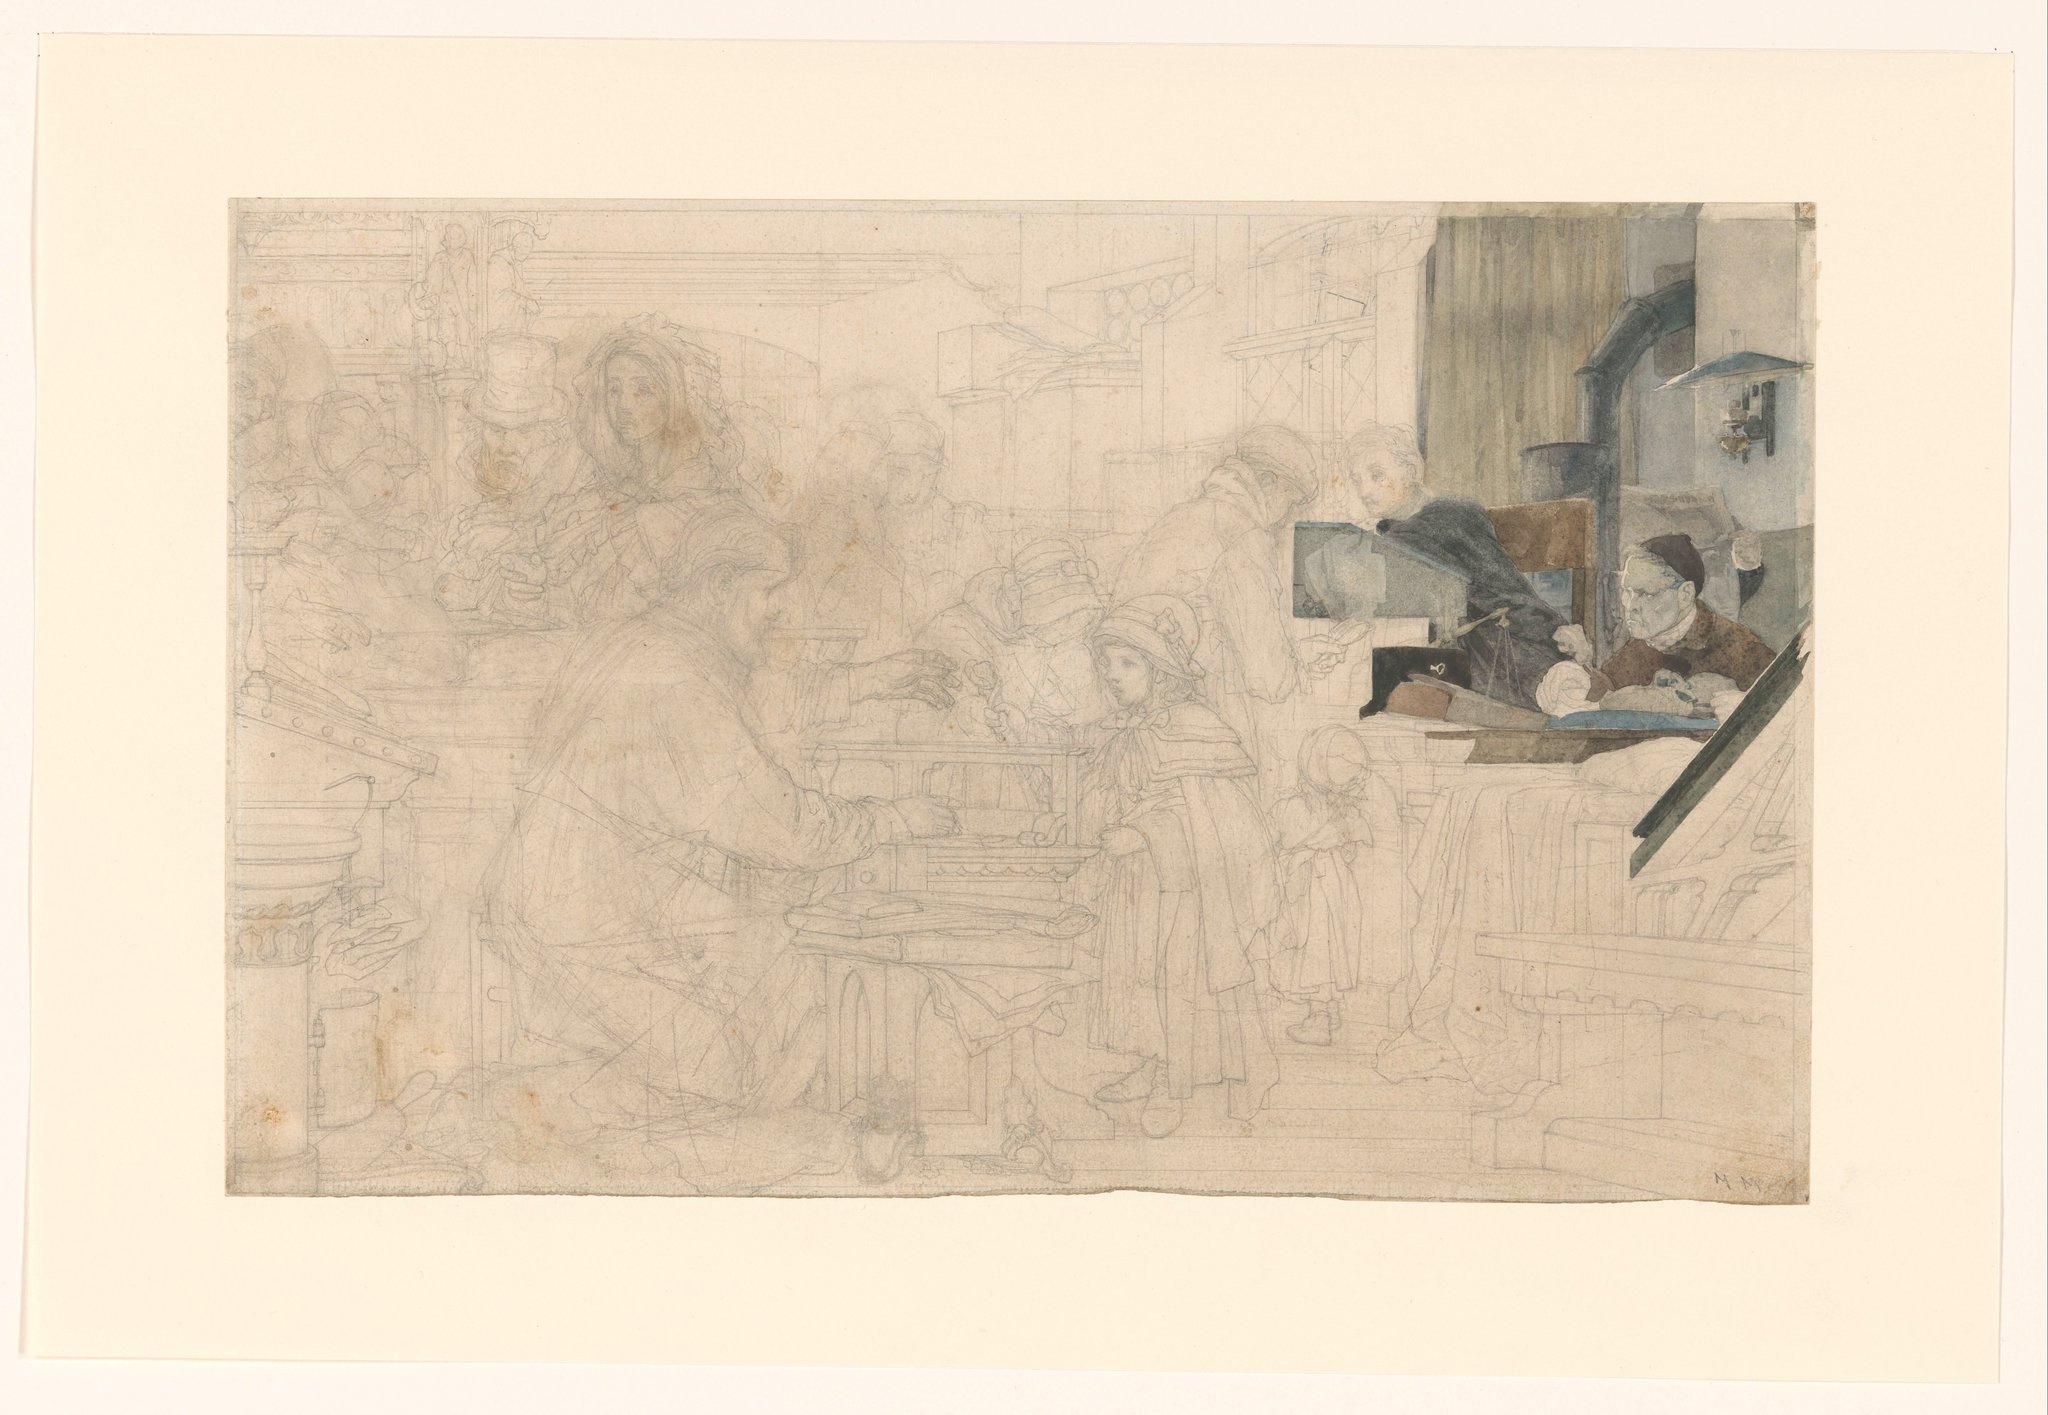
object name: drawing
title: The Pawnshop (Mount of Piety)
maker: matthijs maris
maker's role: draughtsman, painter, print maker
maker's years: 1839-1917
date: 1856-1857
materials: paper, pencil, watercolor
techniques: brush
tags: pawnbroker, lombard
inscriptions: signature: ‘M M’